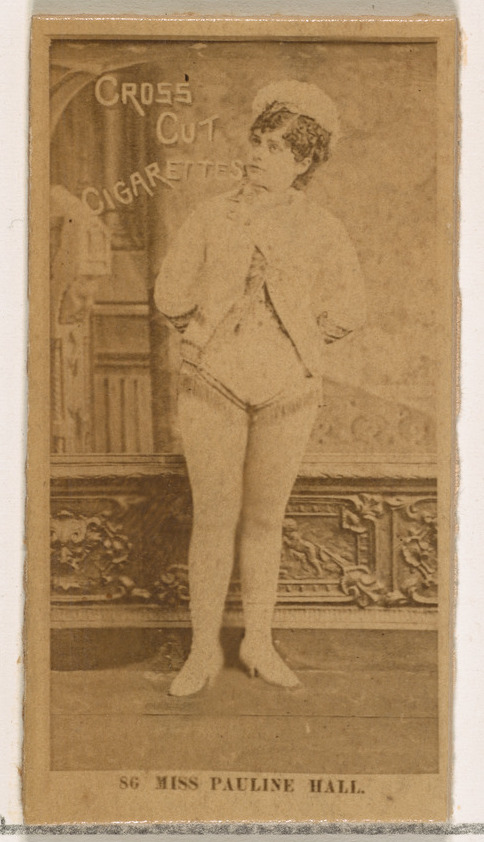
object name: print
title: Card Number 86, Miss Pauline Hall, from the Actors and Actresses series (N145-2) issued by Duke Sons & Co. to promote Cross Cut Cigarettes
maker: w. duke, sons & co.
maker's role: publisher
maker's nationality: american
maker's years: 1870-1920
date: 1880-1889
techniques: albumen silver print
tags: portraits,women,actresses